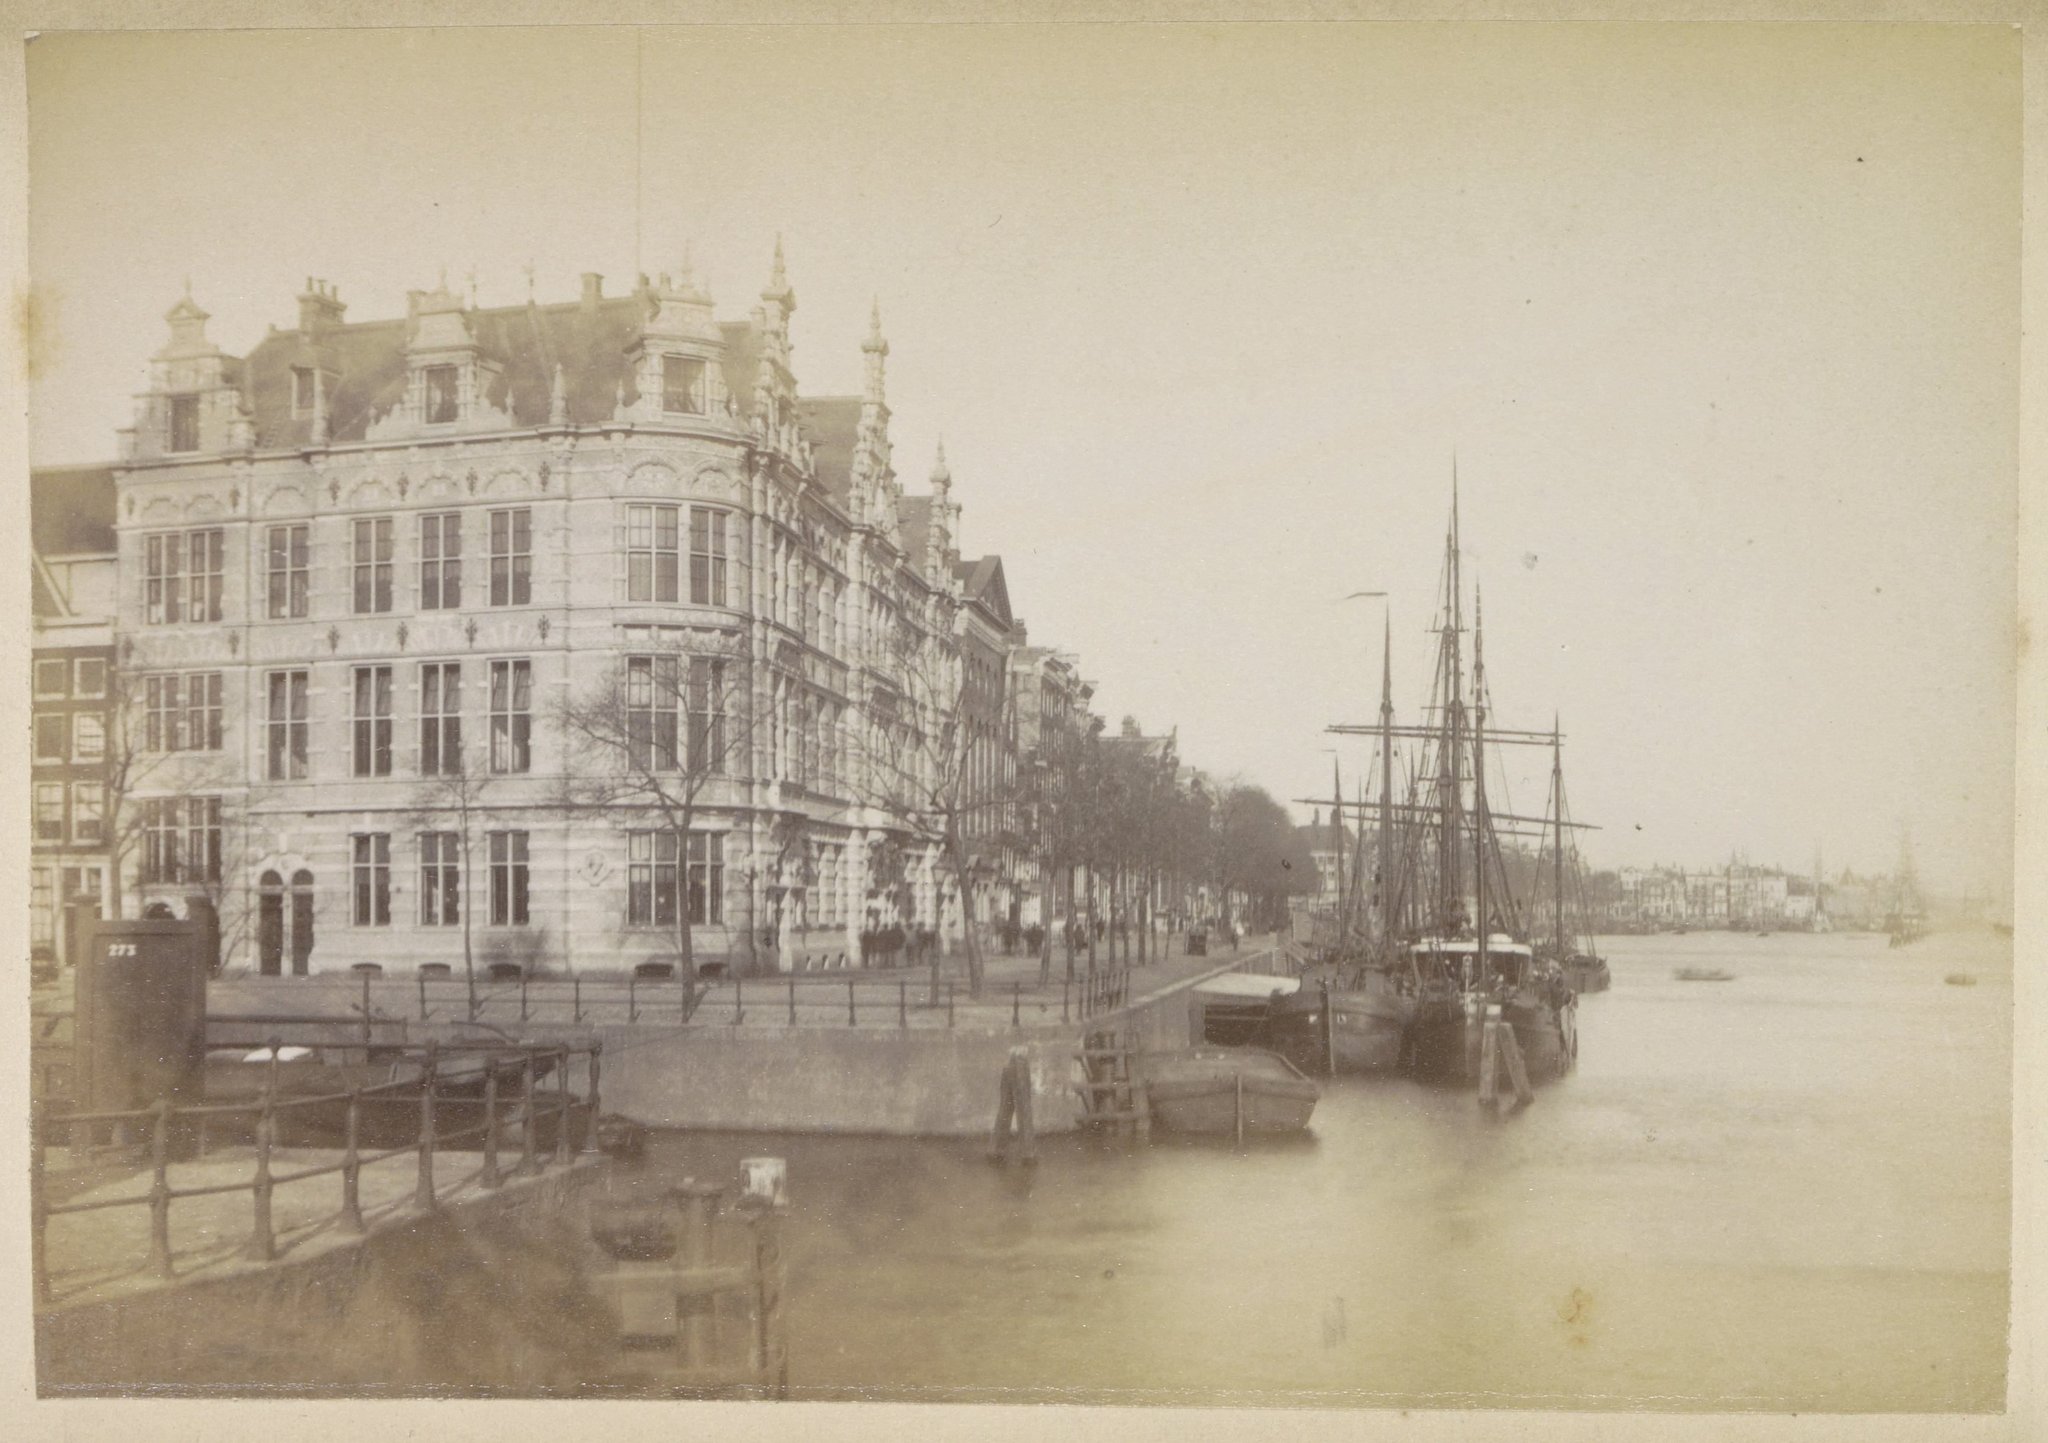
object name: photograph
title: Kweekschool voor de Zeevaart. Amsterdam.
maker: andries jager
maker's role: publisher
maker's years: 1825-1905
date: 1860-1900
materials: cardboard, photographic support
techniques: albumen print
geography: amsterdam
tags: sailing-ship, sailing-boat, higher education, e.g.: teacher's college (+ pupil), façade (of house or building)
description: Onderdeel van Leporelloalbum met 24 foto's van Amsterdam.